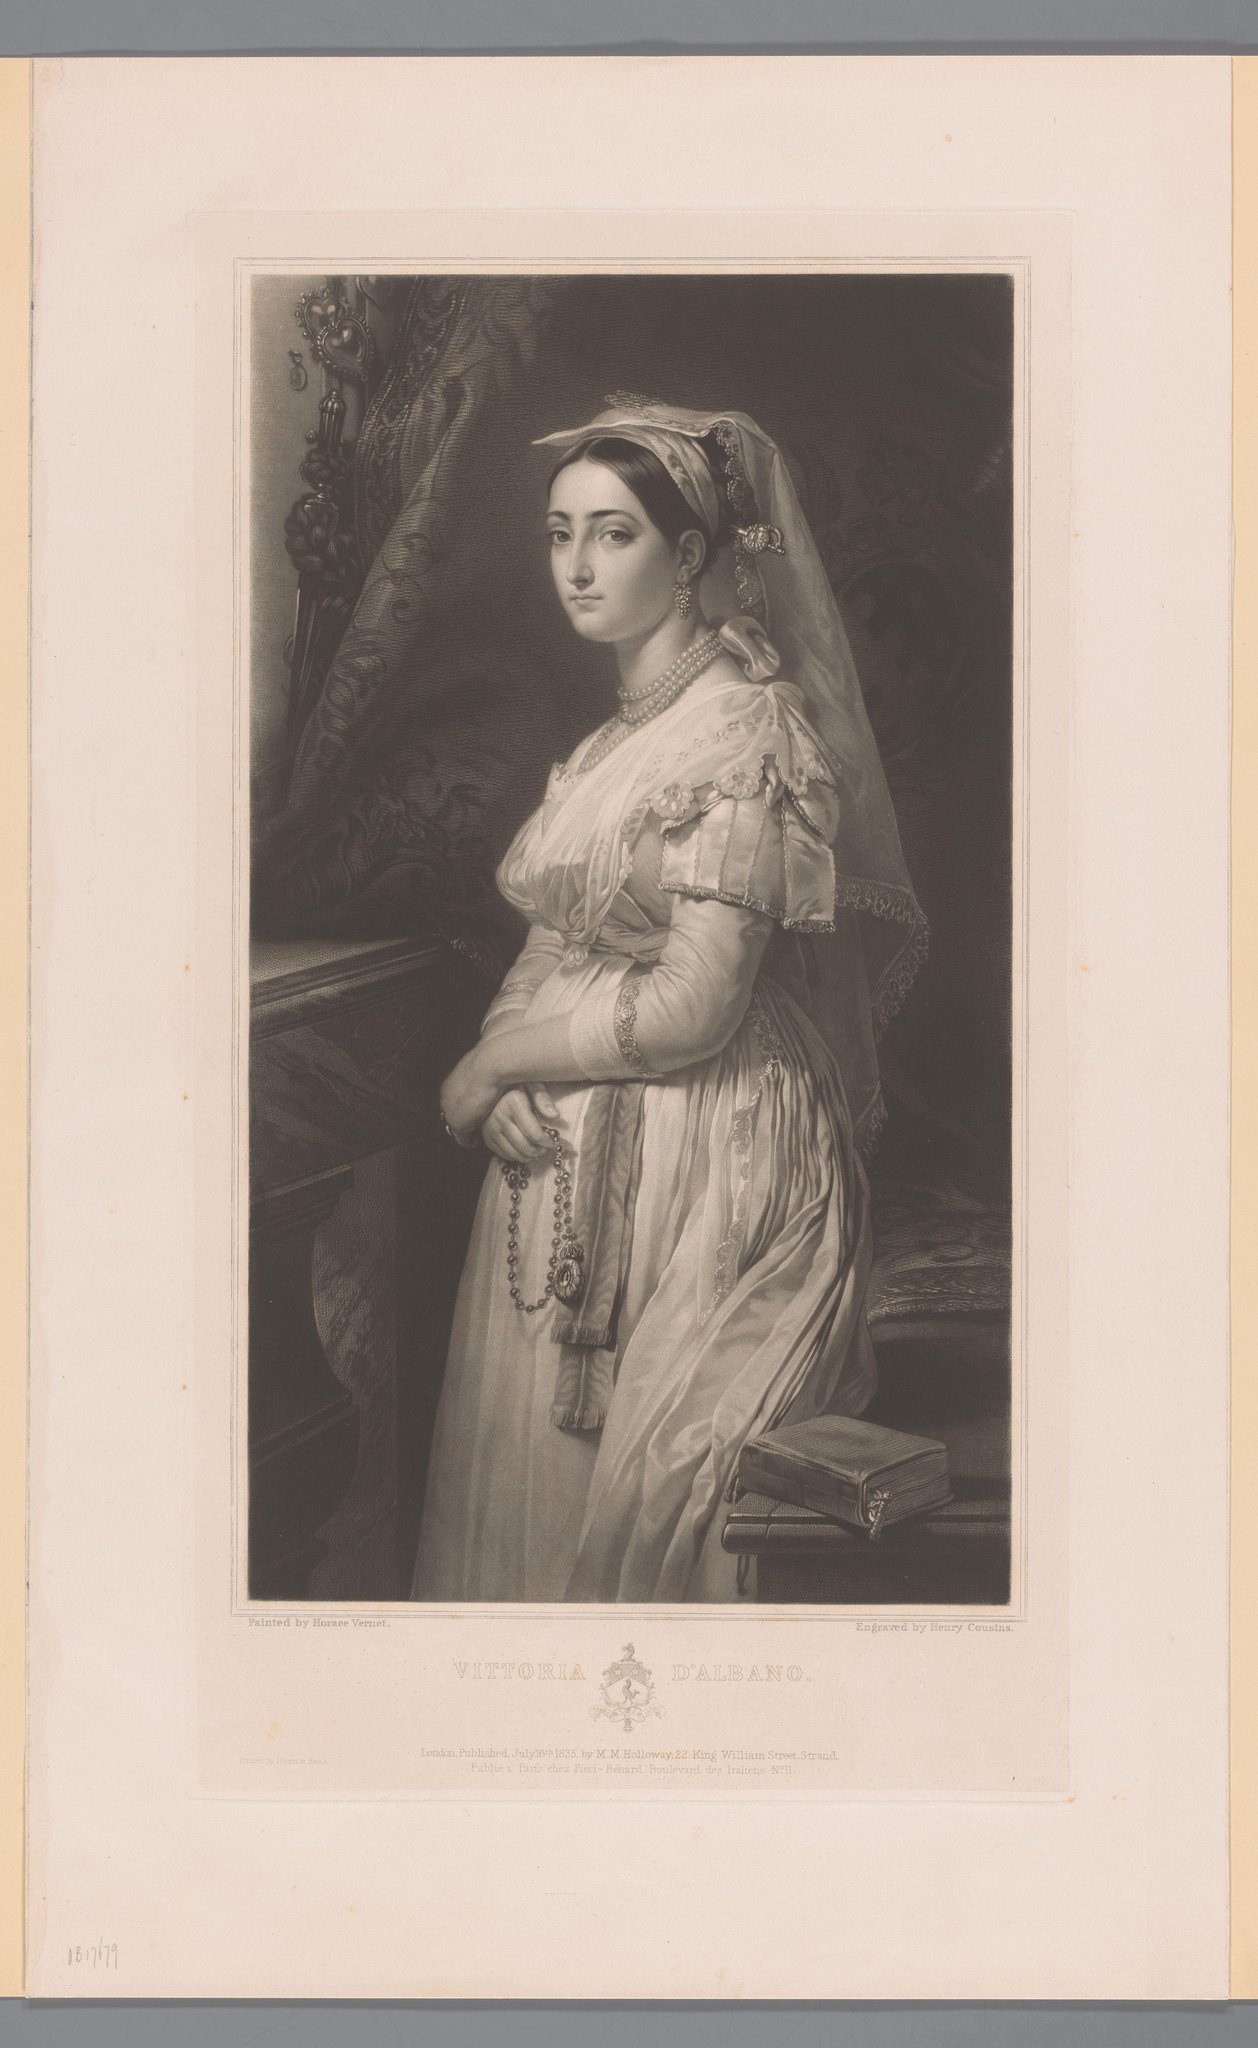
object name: print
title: Portret van Vittoria d'Albano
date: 1835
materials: paper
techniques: mezzotint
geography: paris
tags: historical persons